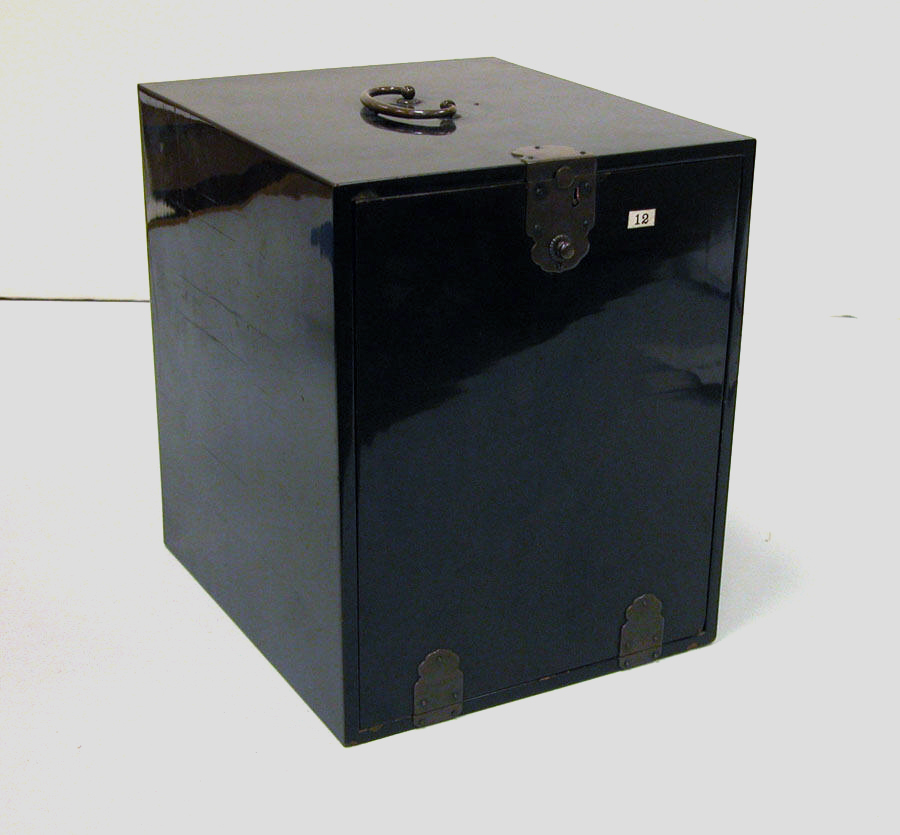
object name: cabinet containing box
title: Cabinet containing boxes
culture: japanese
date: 1701-1900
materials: lacquer